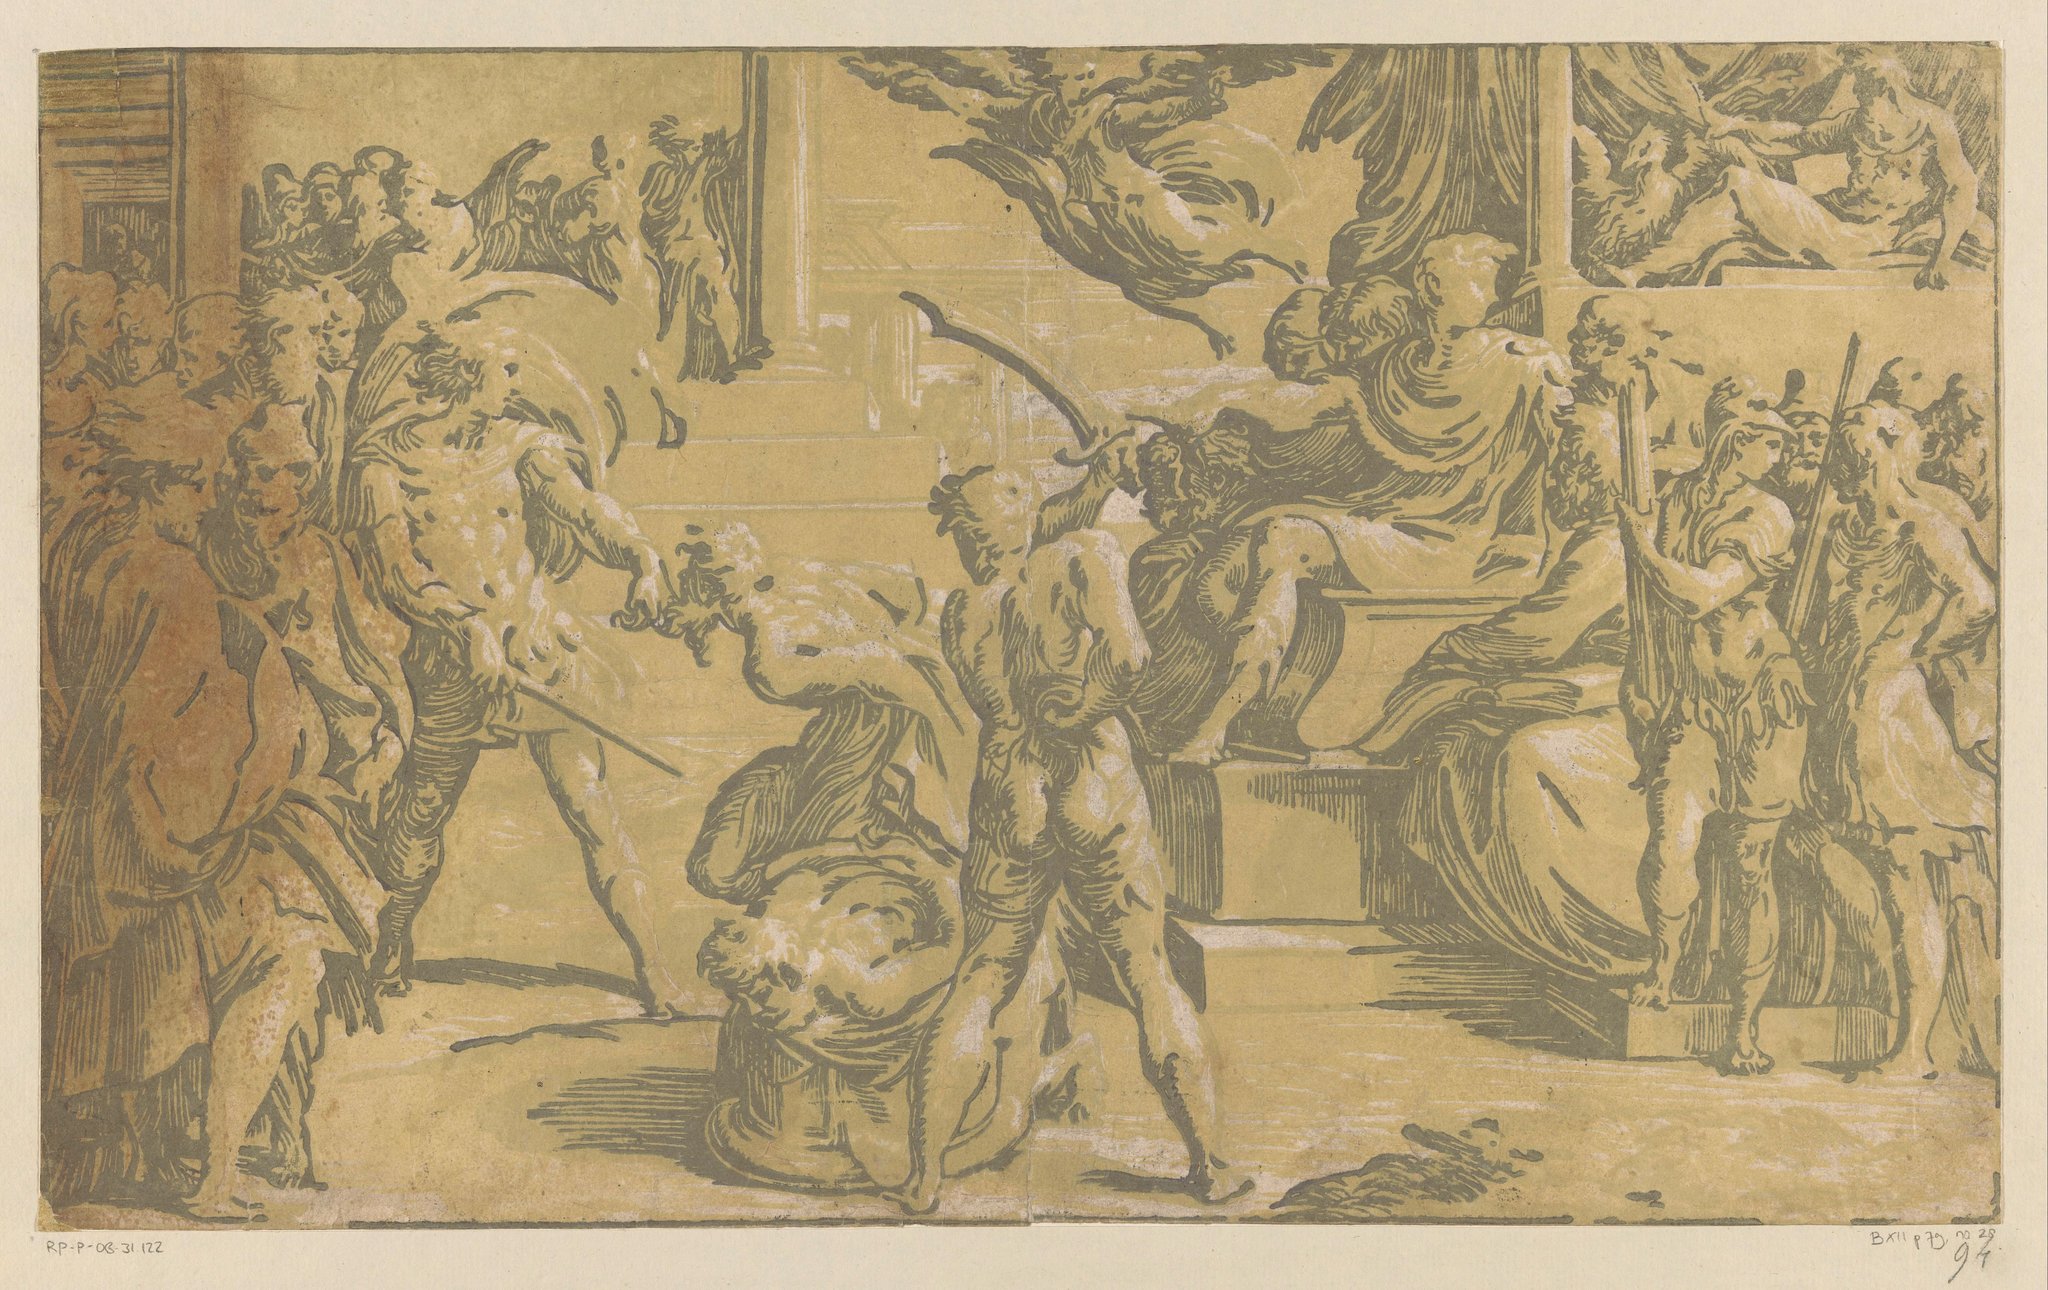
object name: print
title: Martelaarschap van de heiligen Petrus en Paulus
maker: antonio da trento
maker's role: painter, print maker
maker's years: 1510-1550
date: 1520-1550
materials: paper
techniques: woodcut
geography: rome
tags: (story of) jupiter (zeus), martyrdom and death of peter, martyrdom and death of paul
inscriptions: collector's mark: Lugt 240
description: Rechts zit de Romeinse keizer Nero op zijn troon. Voor hem de heiligen Petrus en Paulus. Terwijl een soldaat op het punt staat om Paulus te onthoofden, grijpt een andere soldaat Petrus bij zijn baard. Verscheidene omstanders kijken toe en in de lucht vliegt een engel. Achter de troon van Nero een sculptuur van Jupiter met adelaar.